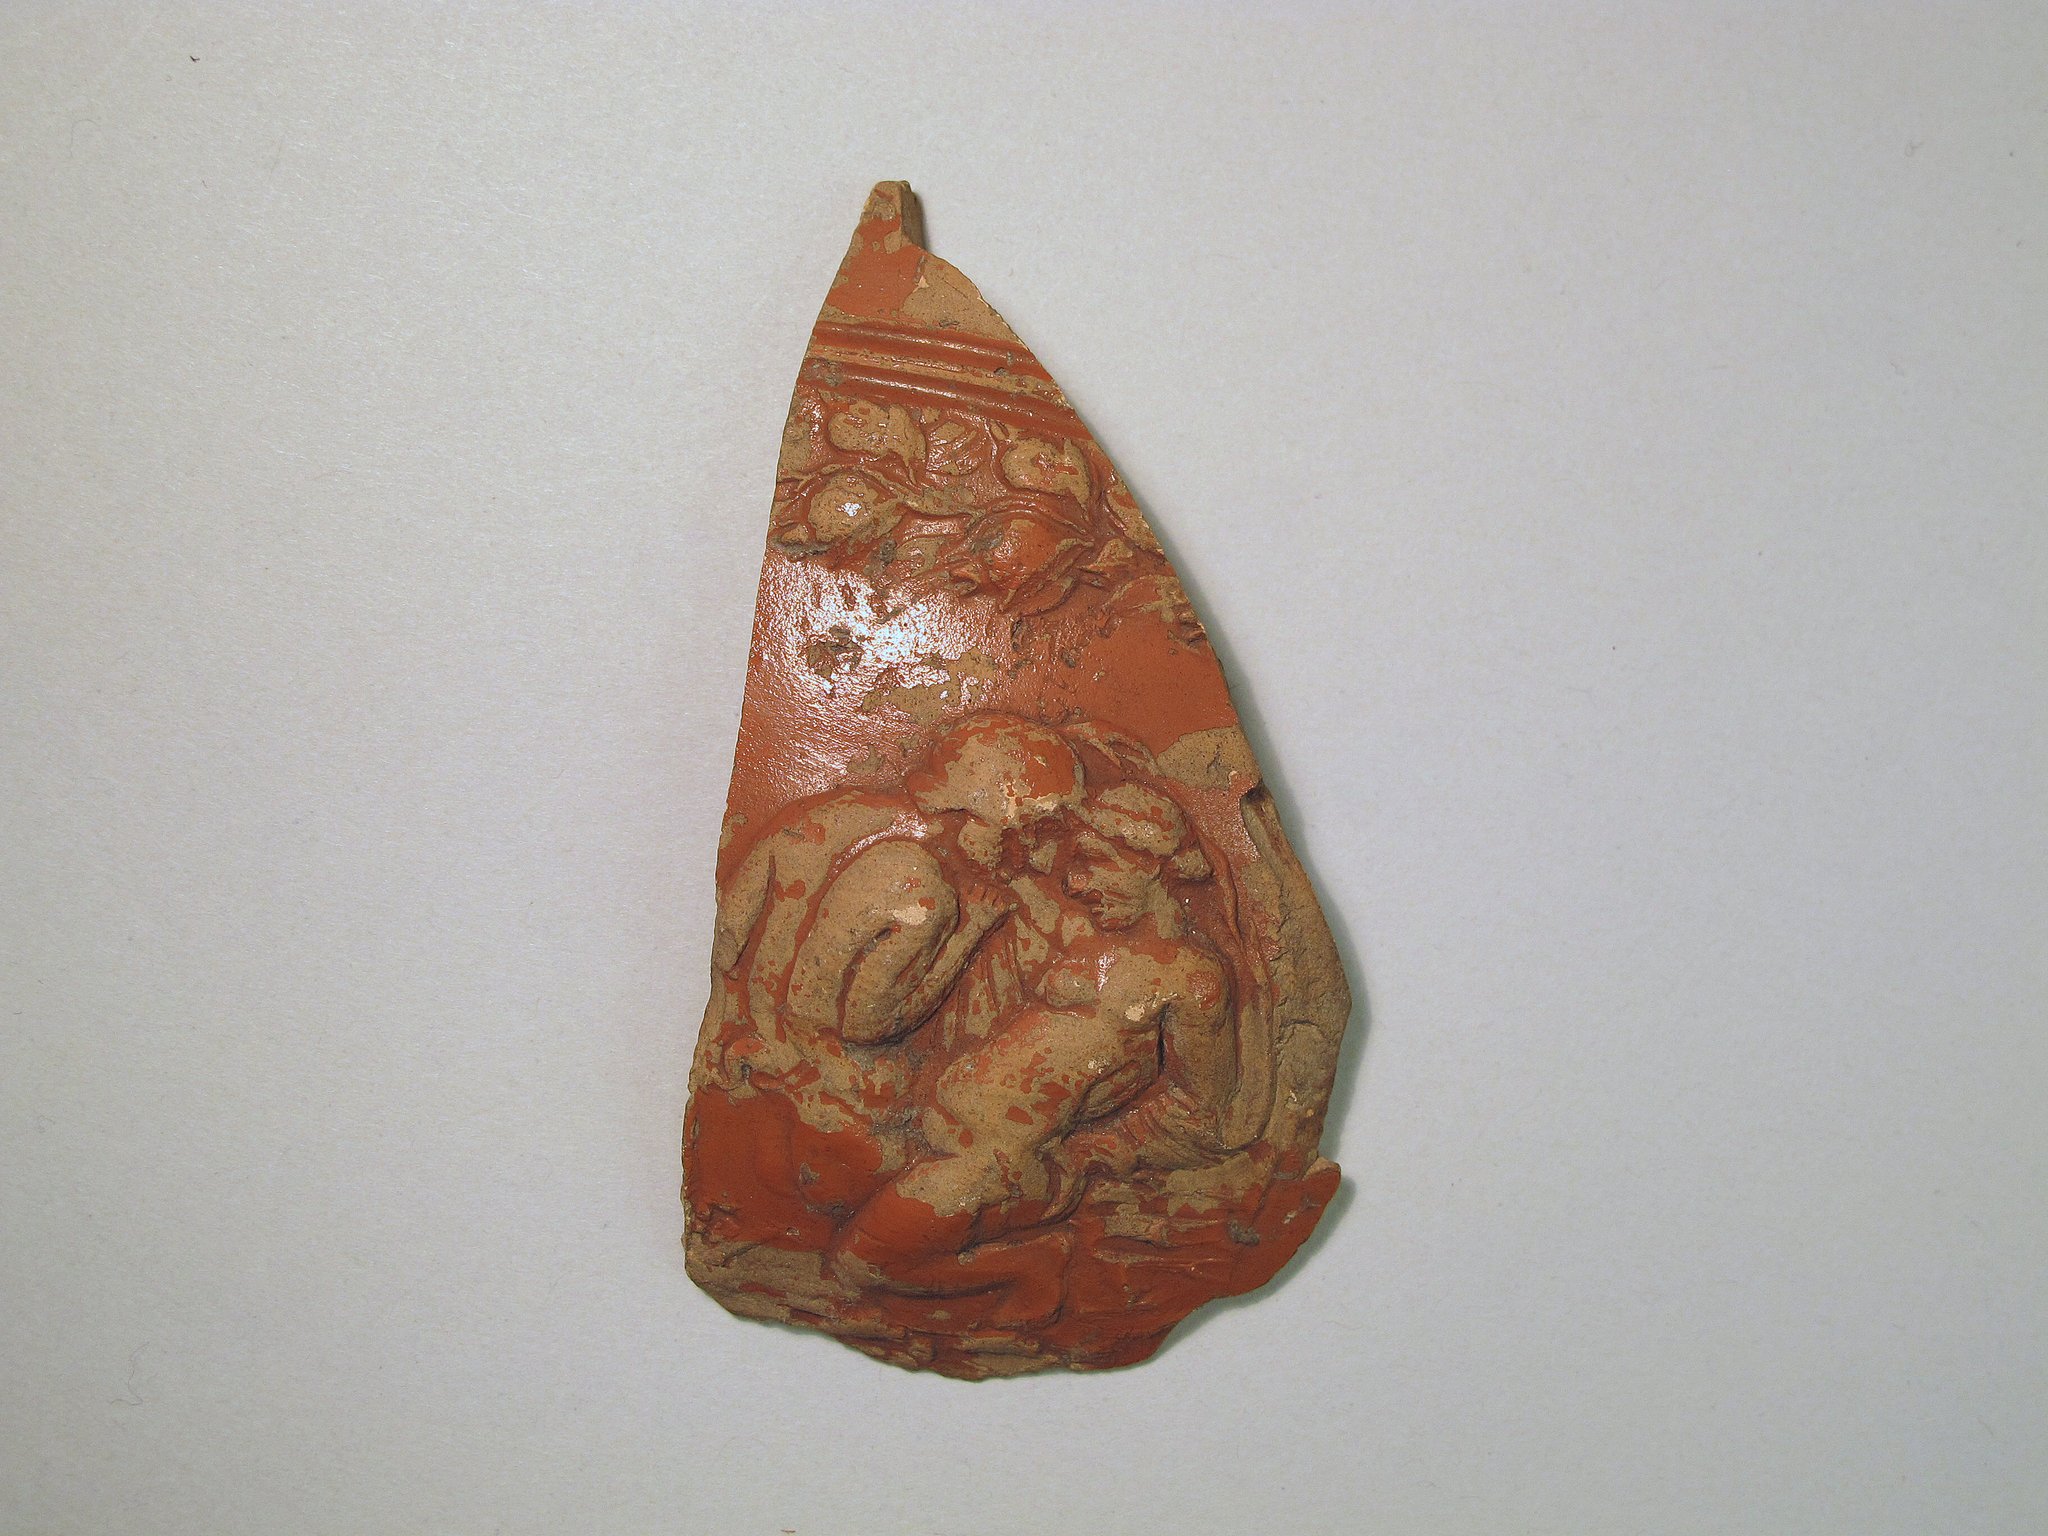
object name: vase fragment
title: Terracotta bowl fragment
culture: roman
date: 15-35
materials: terracotta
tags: female nudes,satyrs